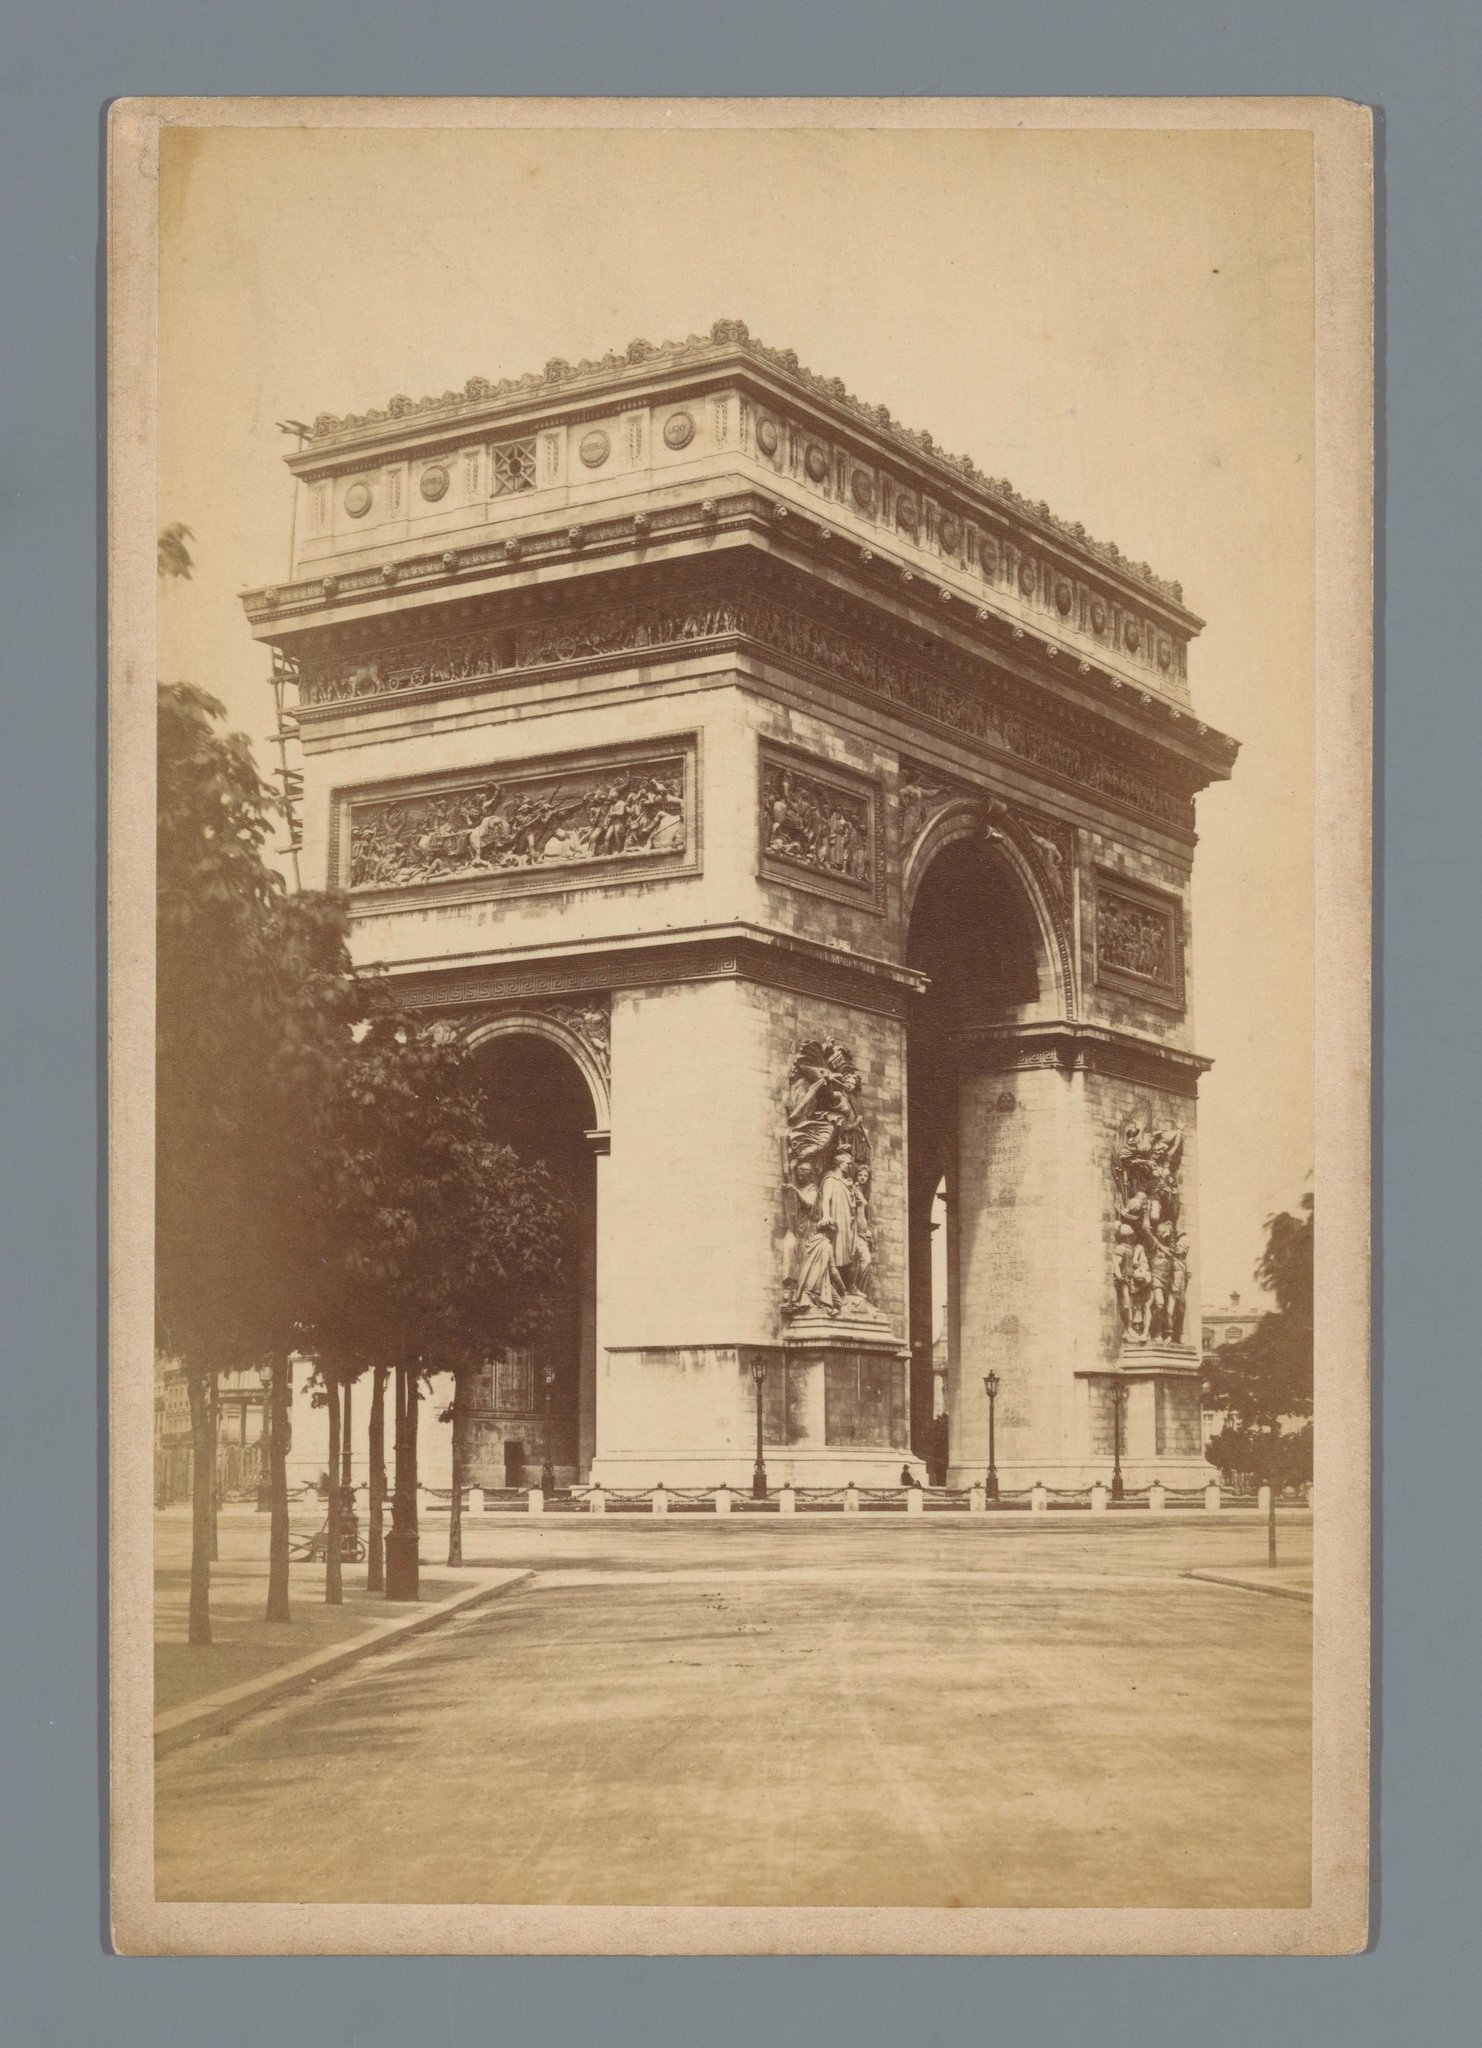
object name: photograph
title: Arc de Triomphe te Parijs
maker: Anonymous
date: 1860-1900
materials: cardboard, photographic support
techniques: albumen print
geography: paris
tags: triumphal arch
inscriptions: annotation: ‘Arc de Triomphe’, number: ‘422’